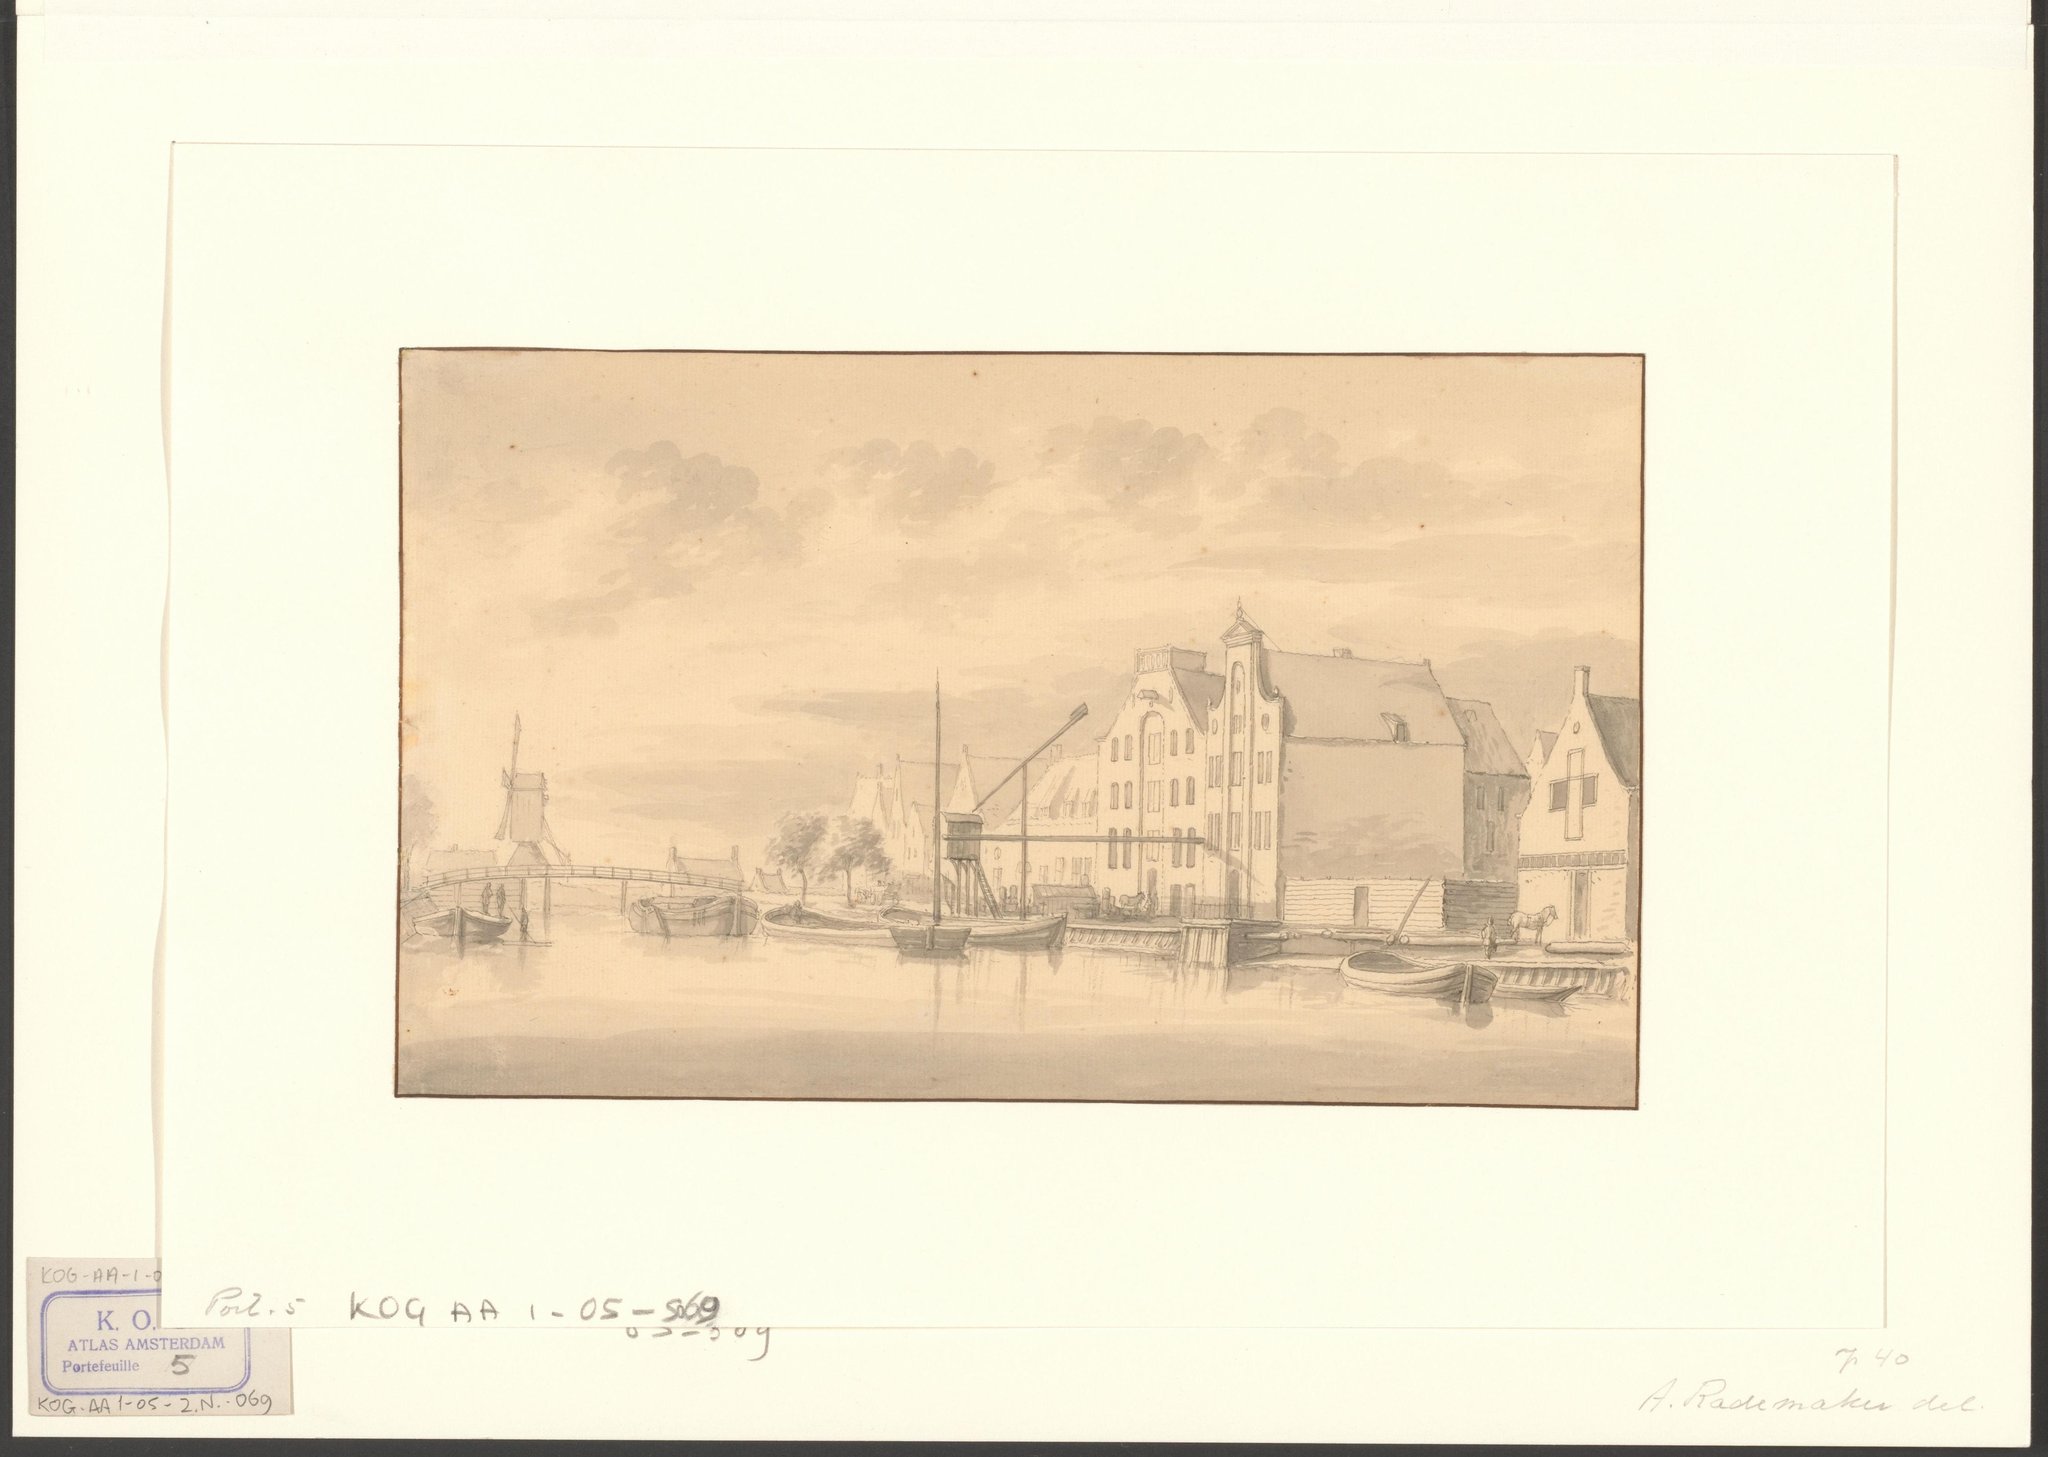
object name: drawing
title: Gezicht op de Brouwersgracht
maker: abraham rademaker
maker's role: draughtsman, print maker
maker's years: 1676-1735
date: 1686-1735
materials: ink, paper, pencil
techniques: brush, pen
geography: amsterdam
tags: sailing-ship, sailing-boat, city-view in general; 'veduta', canal, bridge in city across river, canal, etc., boat propelled by man or animal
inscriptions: collector's mark: ‘5’ Lugt 1641b, inscription: ‘Port. 5’, inscription: ‘A. Rademaker. f. Te Amsterdam op het einde van de Brouwersgracht’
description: Onderwerpsrubriek binnen de Atlas Amsterdam: Begijnensloot (Gedempte), Bagijnhofsteeg, Beulingsloot, Bickersgracht en –plein, Bickersstraat (Groote), Bilderdijkskade en -straat, Binnenkant, Blauwburgwal, Boomdwarsstraat, Brouwersgracht, Bleekersspad (Lange), Bleekerssloot, Bloemgracht, Boerenwetering, Boltensgrachtje, Boomssloot (Recht), Badhuisweg.